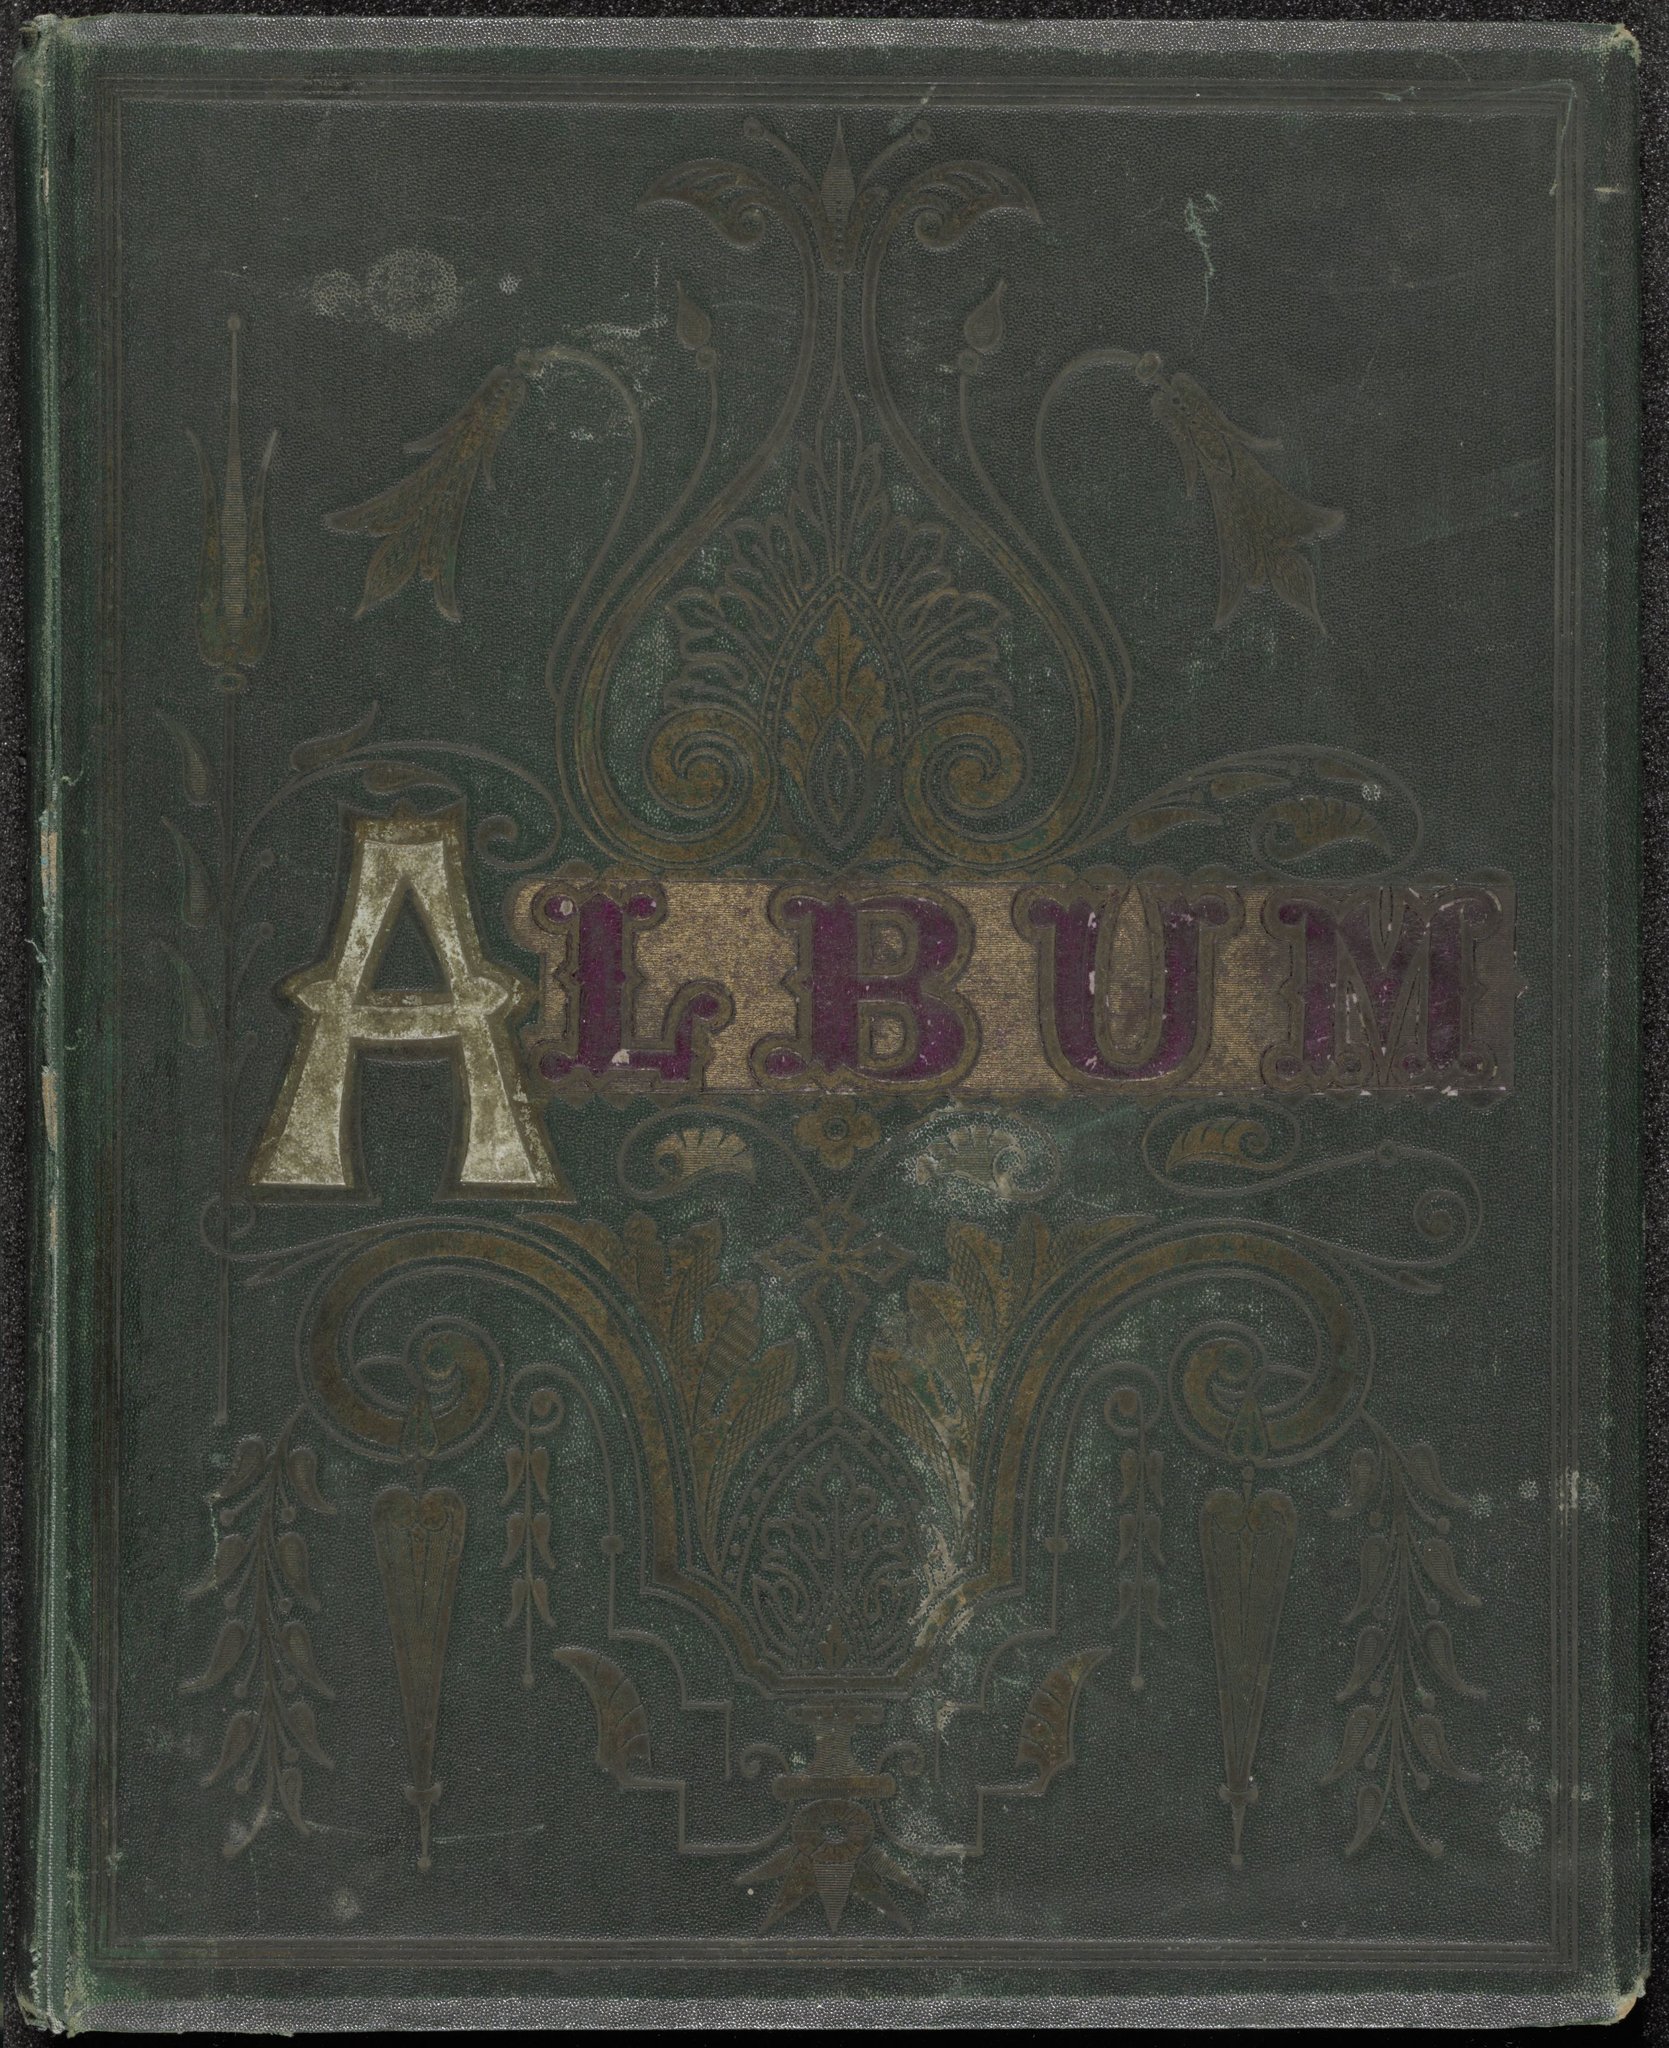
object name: scrapbook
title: Herdenkingsalbum van rooms-katholieke geestelijken gevallen tijdens de Commune van Parijs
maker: Anonymous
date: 1871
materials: cardboard, linen, paper, photographic support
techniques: albumen print, carbon print, writing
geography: london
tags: revolutionary government, priest (roman catholic), historical persons, revolution, revolt, politics, violent death, being killed; being mishandled and maltreated; seeking death - ee - death not certain; wounded person, paris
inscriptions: name: ‘Creswick & Co. Stationers 12. Gt. Portland St.t Oxford Street’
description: Albumblad met groene linnen omslag. Voorplat versierd met goudgekleurde blad- en bloemmotieven in reliëf. Het album bevat 23 bladen van dik papier met in totaal 53 opgeplakte foto's waarvan vier los. De meeste bladen zijn voorzien van Engelse, Franse en Latijnse teksten in rode en zwarte inkt, vooral spreuken uit bijbelboeken; ook tekeningen van kruisen en kronen en uitgeknipte afbeeldingen van onderscheidingen. De foto's zijn voornamelijk portretten van rooms-katholieke geestelijken die omgekomen zijn ten tijde van de Commune van Parijs, een revolutionaire regering die aan het bewind was van maart tot en met mei 1871 en hiermee verband houdende afbeeldingen. De samensteller is mogelijk een Engelsman uit Londen.